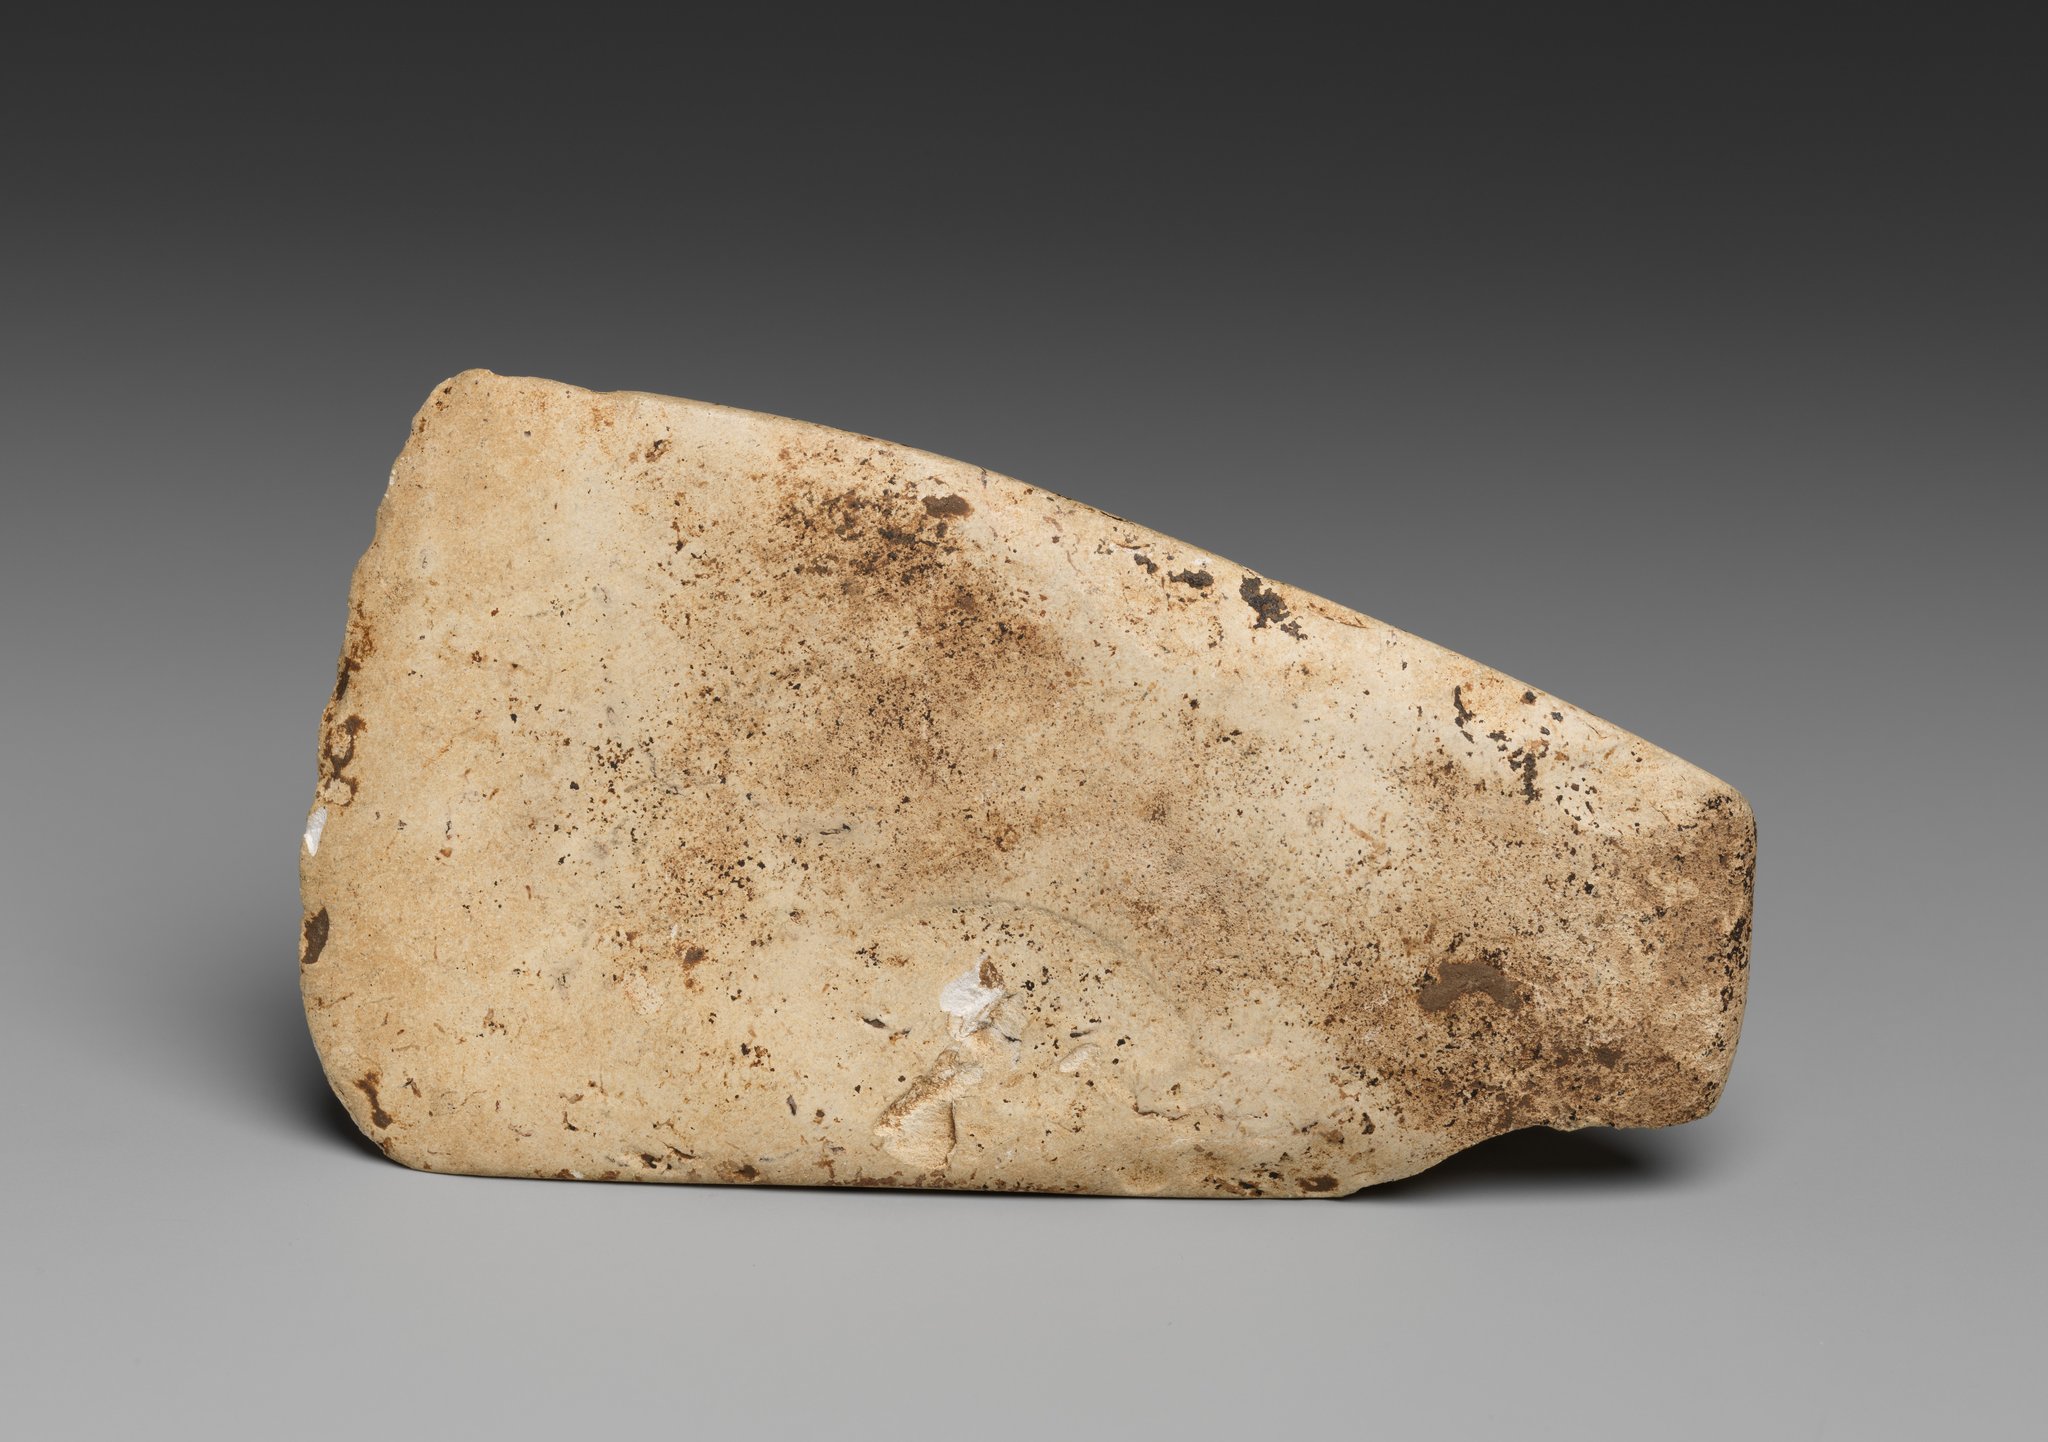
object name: axehead, mottled brown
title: Stone axehead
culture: greek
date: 5000-4000 BCE